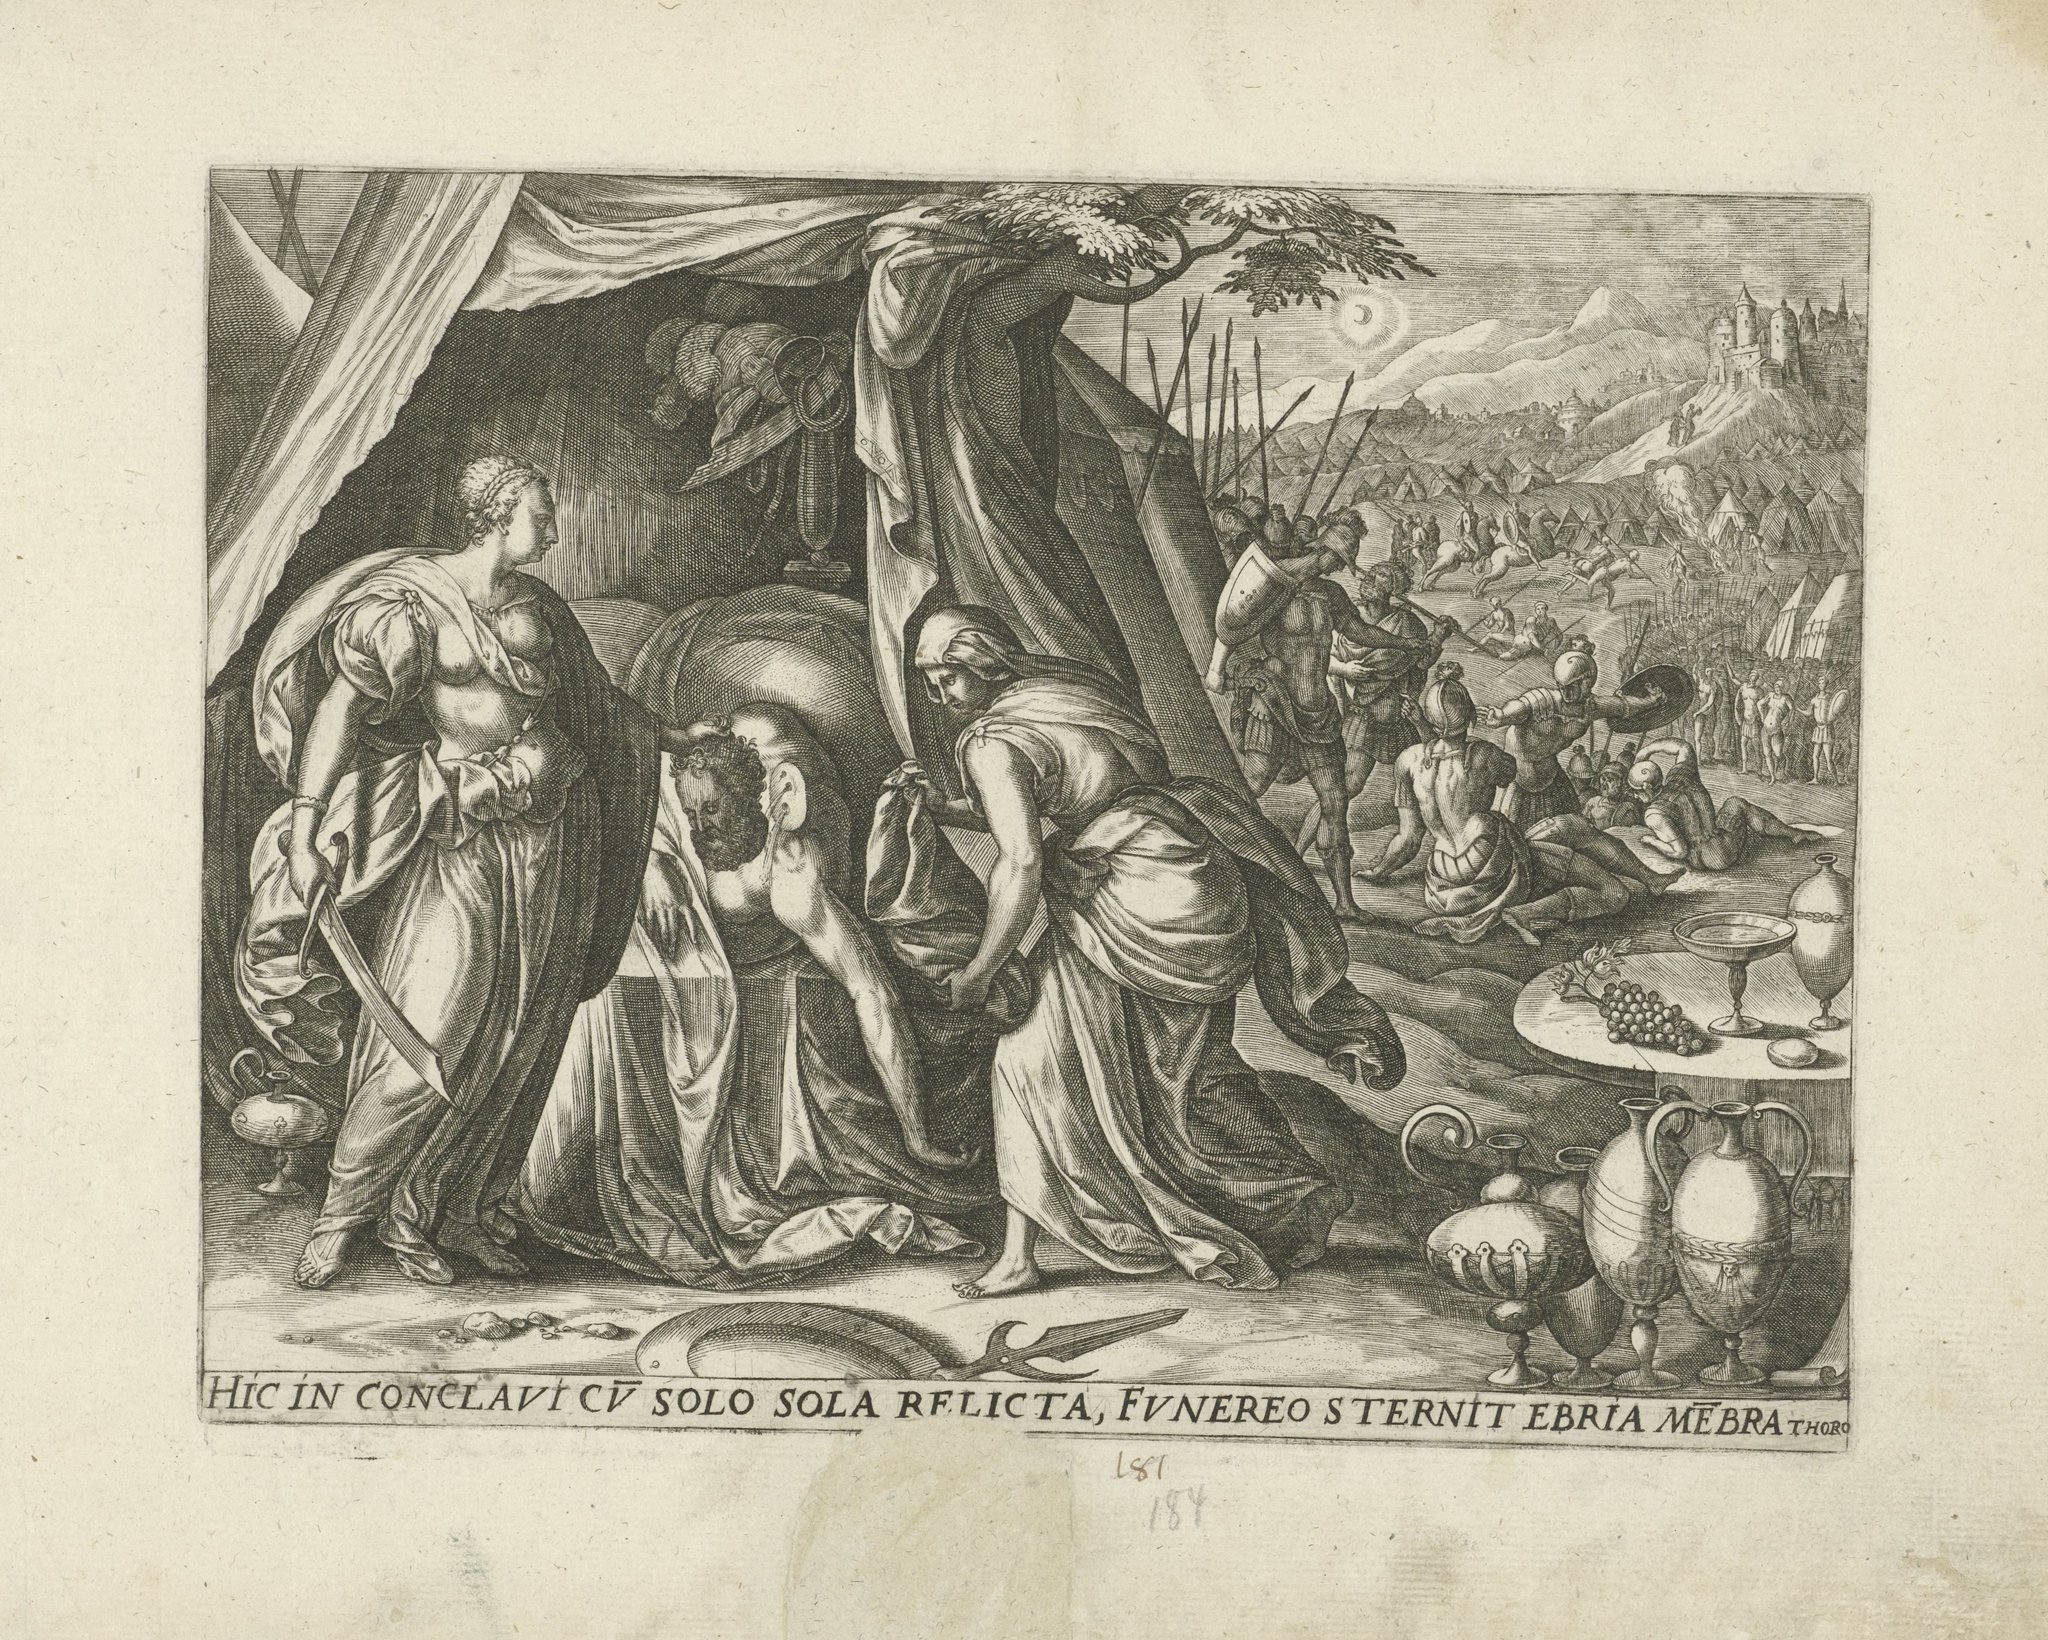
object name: print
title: Judit met hoofd van Holofernes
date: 1547-1591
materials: paper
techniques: engraving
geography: antwerp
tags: holofernes beheaded by judith with his own sword; the maidservant may be keeping watch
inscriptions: inscription: ‘181’, collector's mark: Lugt 2228, collector's mark: Lugt 2760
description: Judit staat met het hoofd van Holofernes en een zwaard in de handen bij de tent. Een dienstmaagd houdt een zak klaar om het hoofd in te doen. Op de achtergrond het kamp met vechtende soldaten. In de marge een onderschrift in het Latijn. Prent uit een serie van vier met scènes uit het verhaal over Judit en Holofernes.